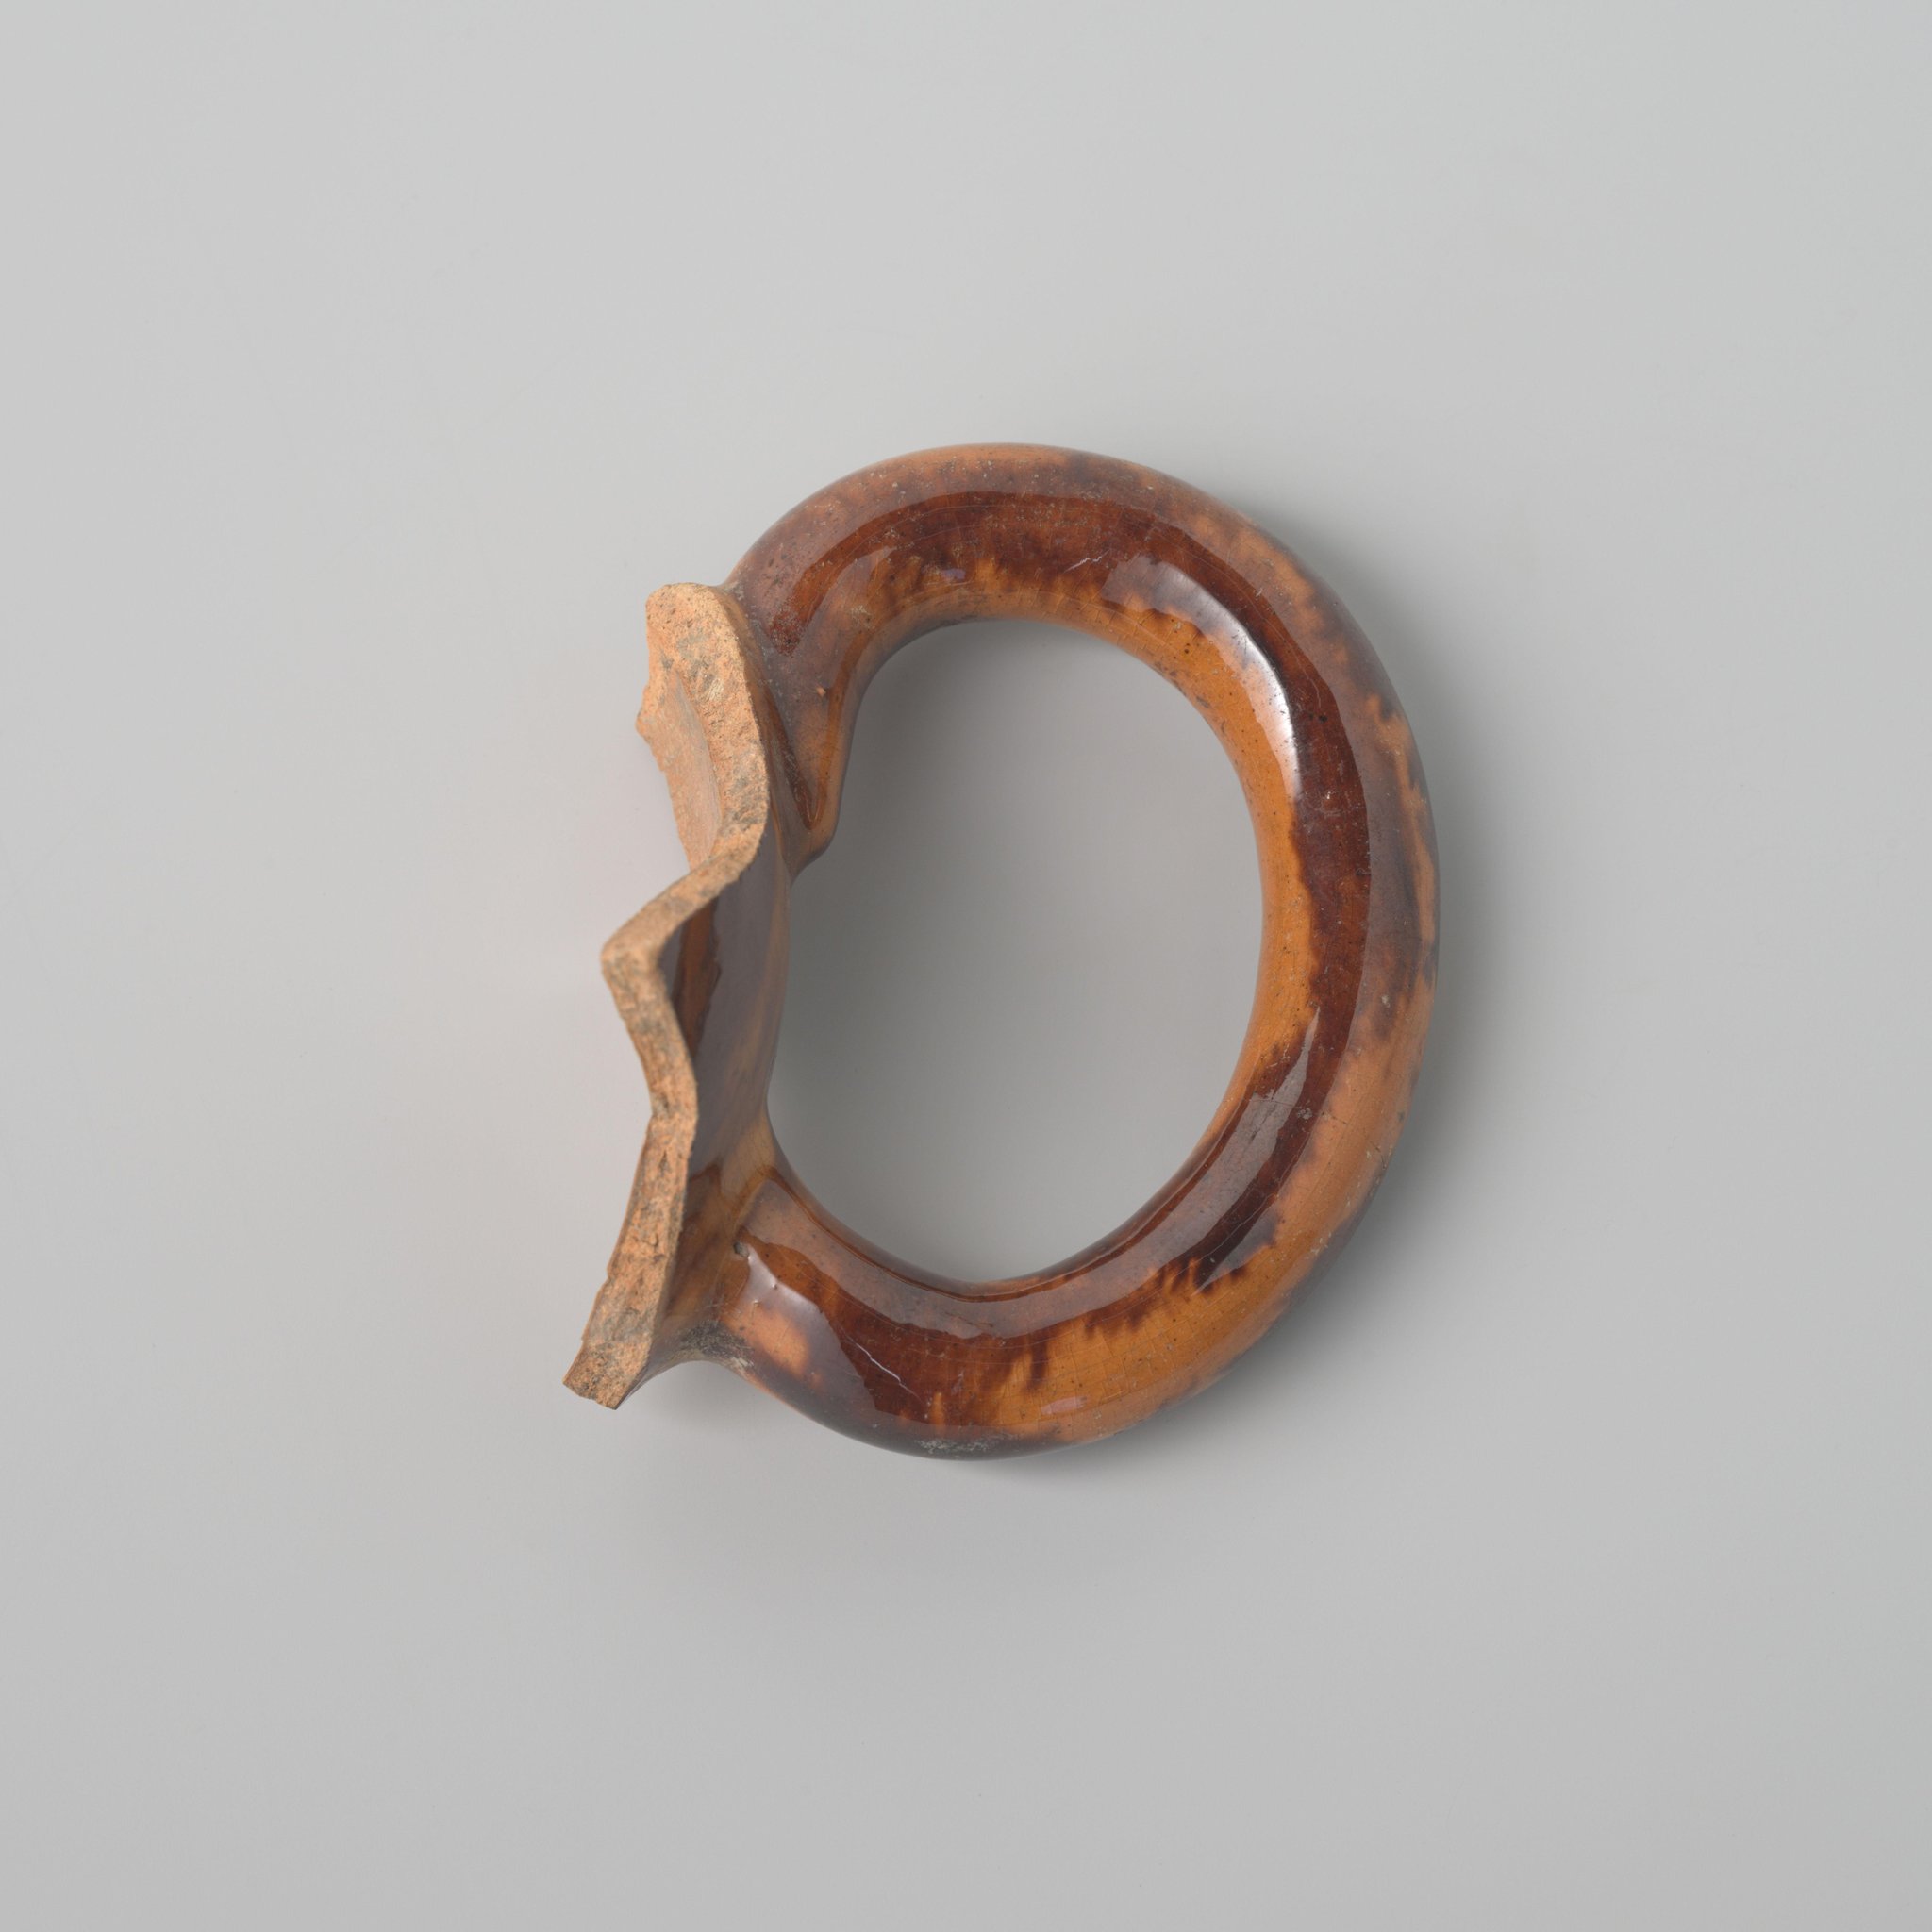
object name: bakafval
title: Oor van een theepot (De Caluwe bakafval)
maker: jacobus de caluwe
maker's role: plateelbakkerij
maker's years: -1730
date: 1700-1725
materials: earthenware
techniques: firing, vitrification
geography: delft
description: Toegeschreven aan Jacobus de Caluwe, omdat dit voorwerp samen met gemerkte stukken (‘Jacobus De Caluwe’ en rennend hert) gevonden is op de plaats waar zich De Caluwes tweede werkplaats bevond. Er is een duidelijke stilistische overeenkomst tussen de gemerkte en niet gemerkte voorwerpen uit deze archeologische vondst.